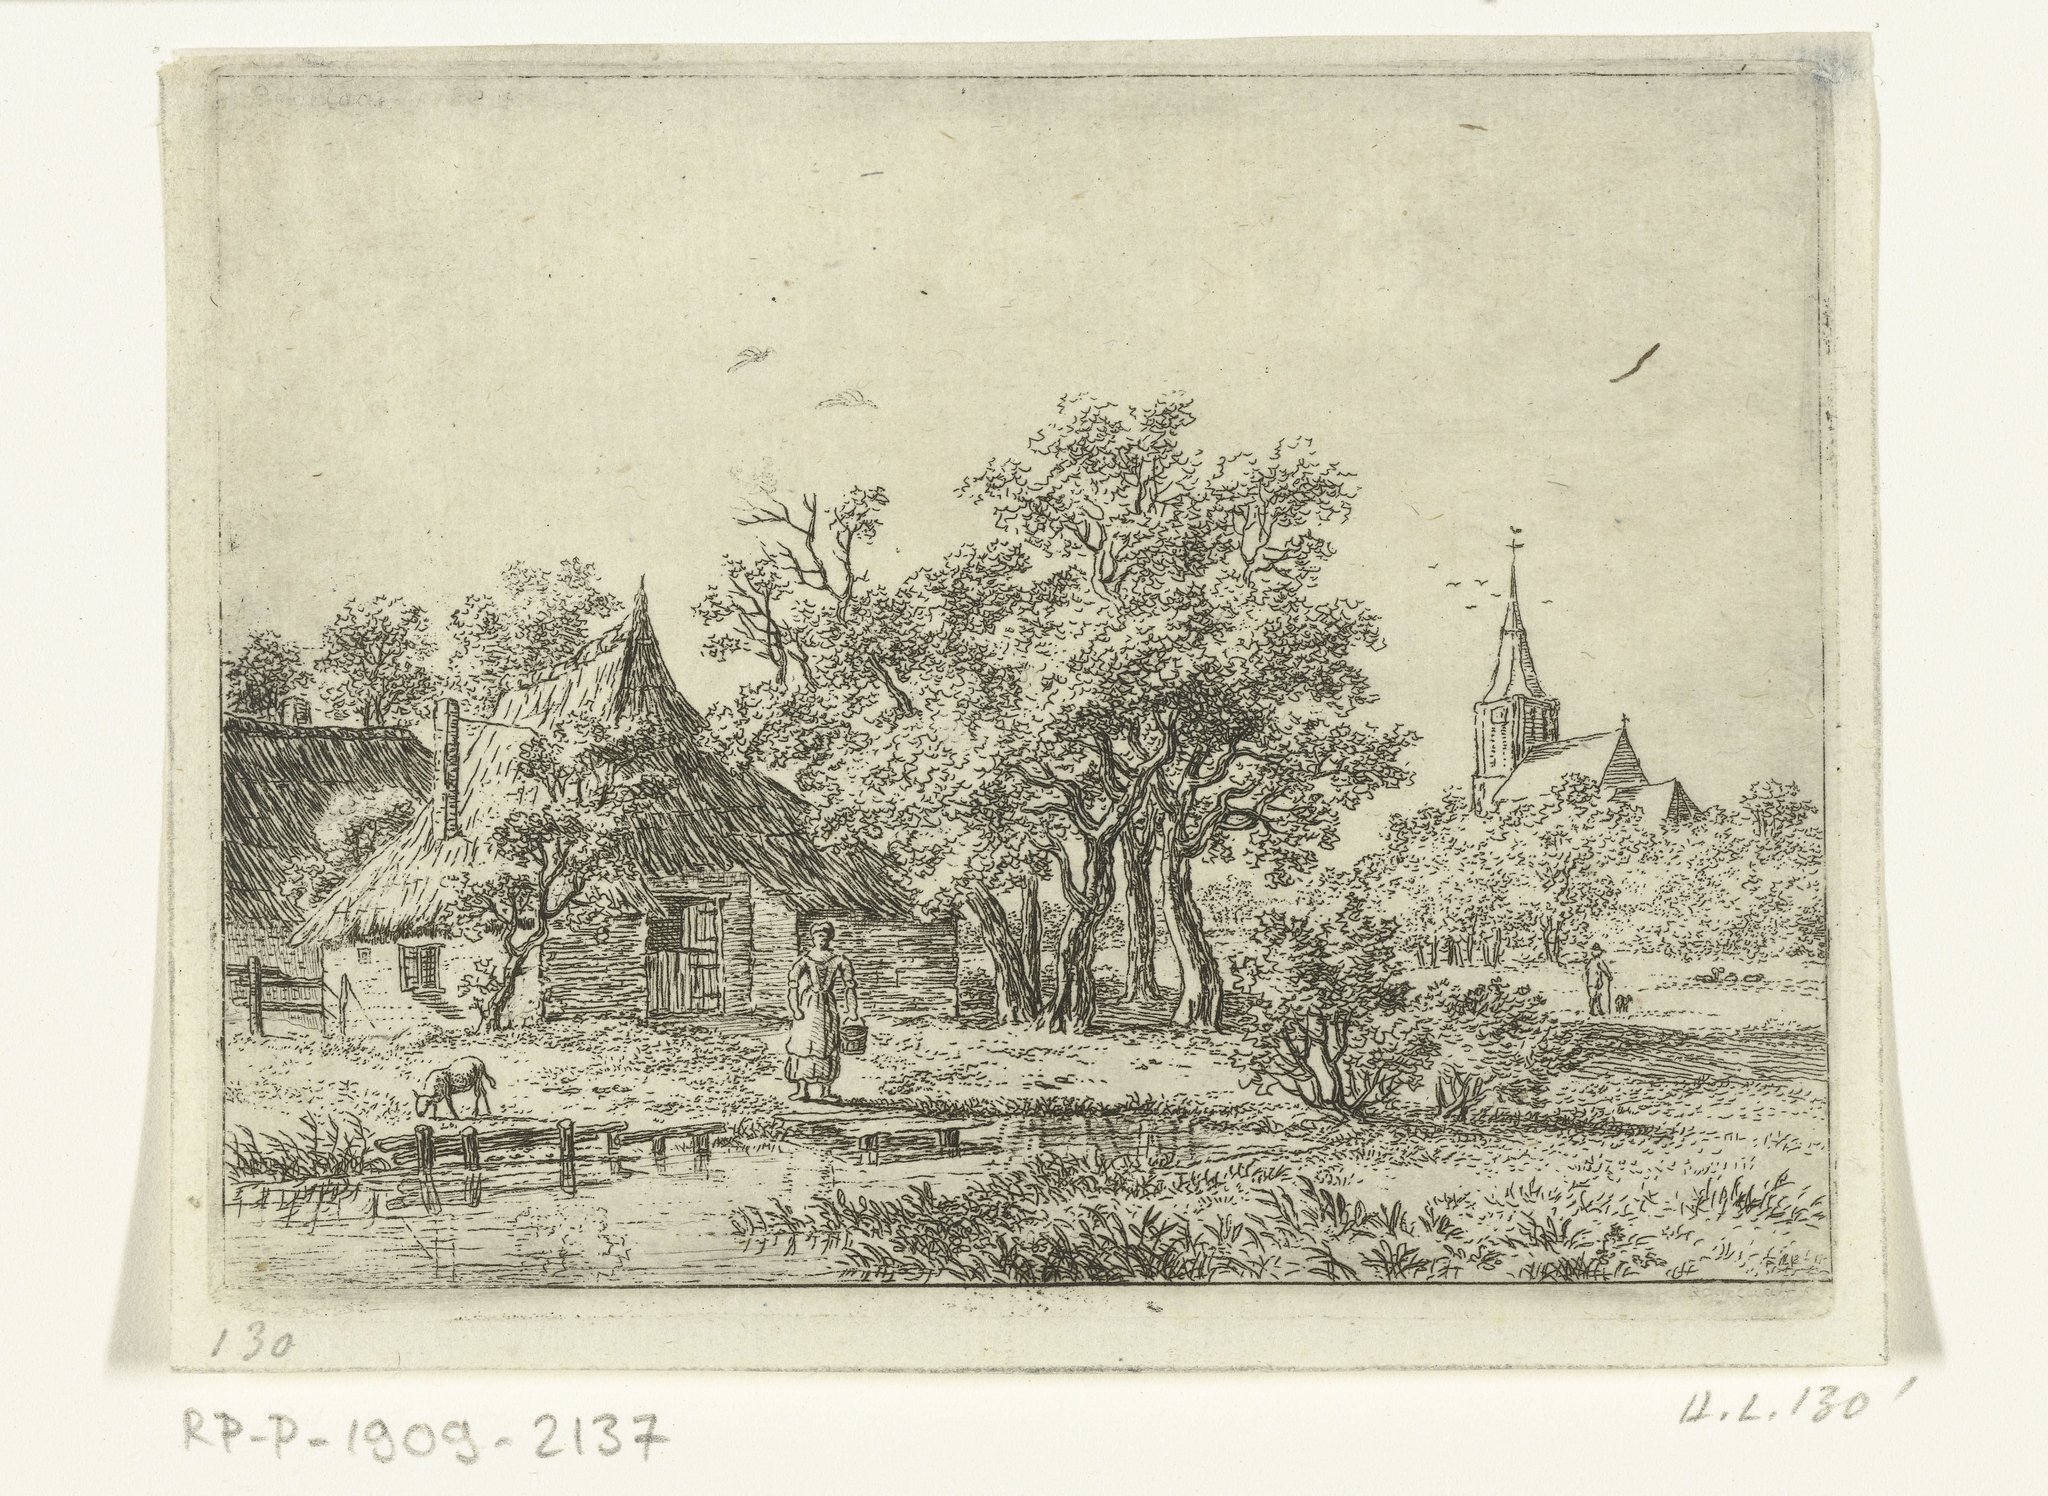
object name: print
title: Dorpsgezicht met maagd die water uit de sloot haalt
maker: ernst willem jan bagelaar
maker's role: draughtsman, print maker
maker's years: 1775-1837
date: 1798-1824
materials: paper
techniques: etching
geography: netherlands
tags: village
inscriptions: collector's mark: Lugt 2228